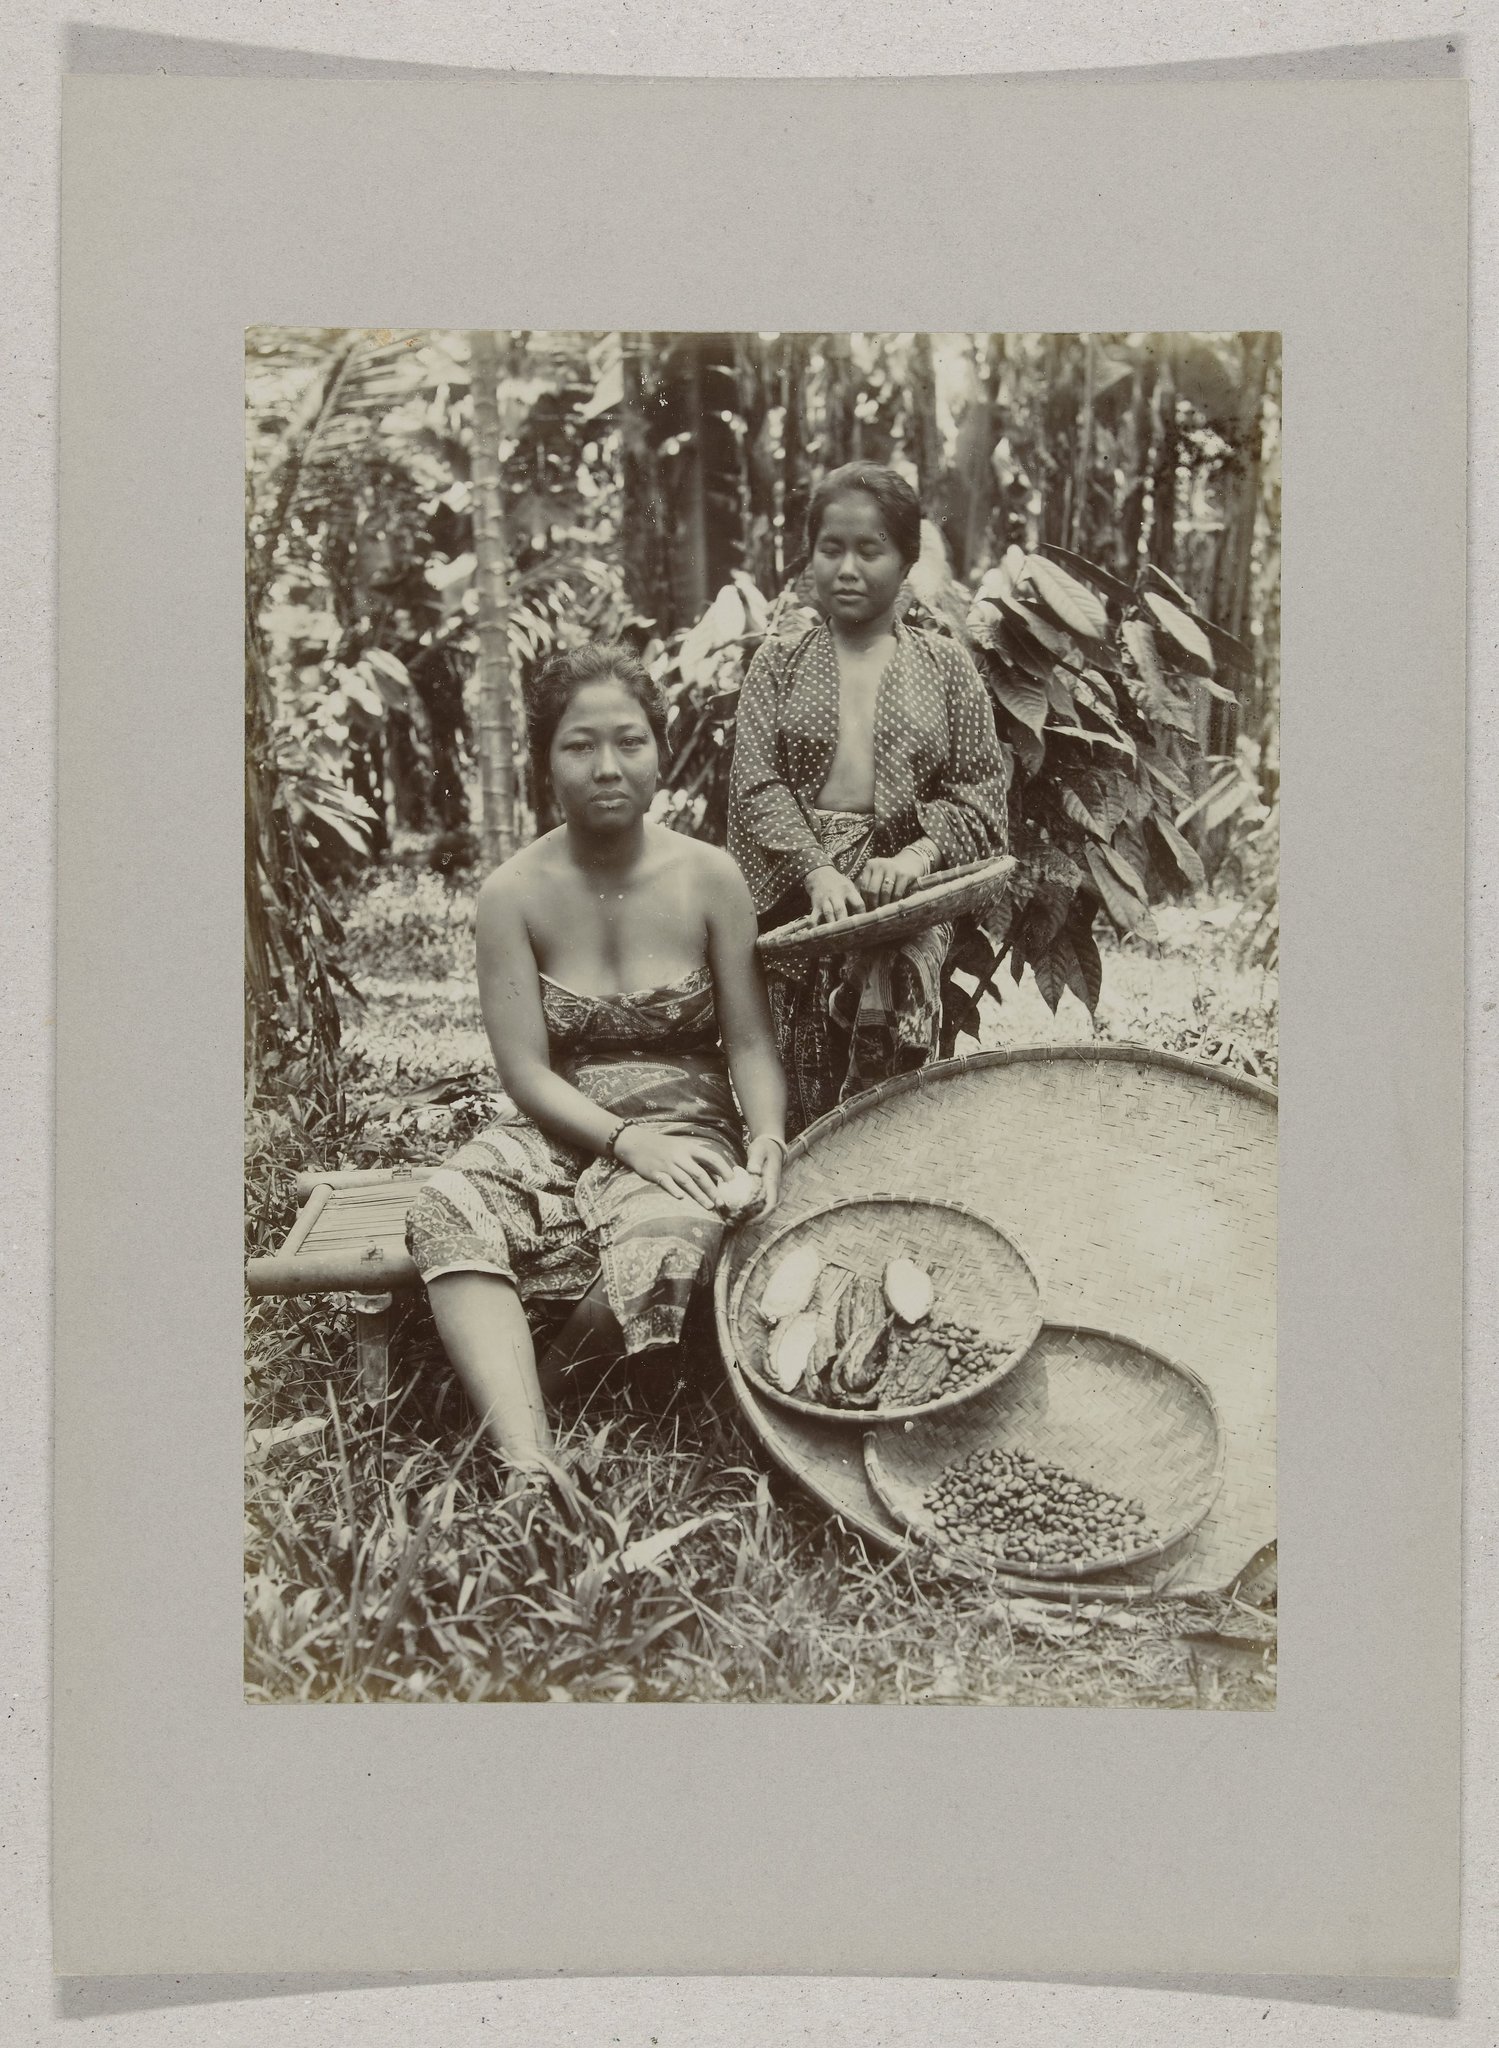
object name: photograph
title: Vrouwen ontbolsteren cacao in Buitenzorg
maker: Anonymous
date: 1895-1915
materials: cardboard, paper, photographic support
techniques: gelatin silver print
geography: dutch east indies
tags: dutch east indies, the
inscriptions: number: ‘28’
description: Vrouwen ontbolsteren cacao te Buitenzorg (Bogor), Nederlands-Indië.